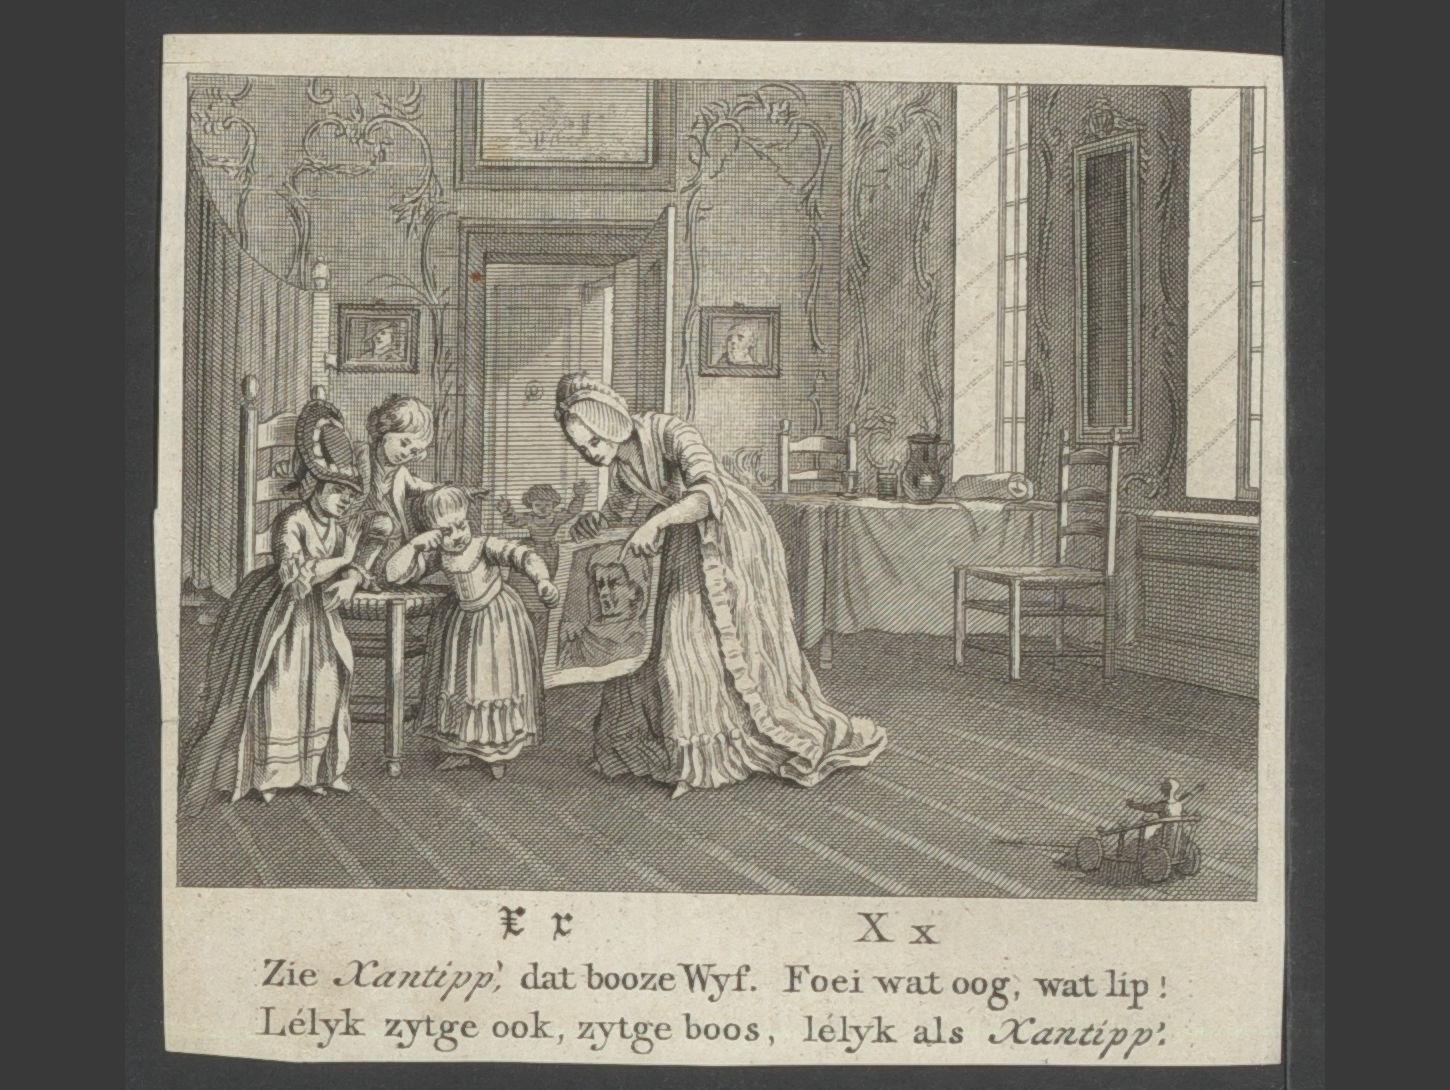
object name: book illustration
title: Moeder toont haar kinderen een prent van Xantippe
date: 1781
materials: paper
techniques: engraving, etching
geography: amsterdam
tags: mother with son(s) and daughter(s) (mother-love), letters, alphabet, script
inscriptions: stamp, collector's mark: Lugt 1641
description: Moeder toont haar kinderen een prent van Xantippe. Onder de voorstelling de letter X in twee verschillende lettertypes. Onderaan een tweeregelig vers over Xantippe. Onderwerpsrubrieken binnen de Atlas Zeden en Gewoonten: Onderwijs en Wetenschappen, Opvoeding en Onderwijs, Haneboeken en schoolprenten.